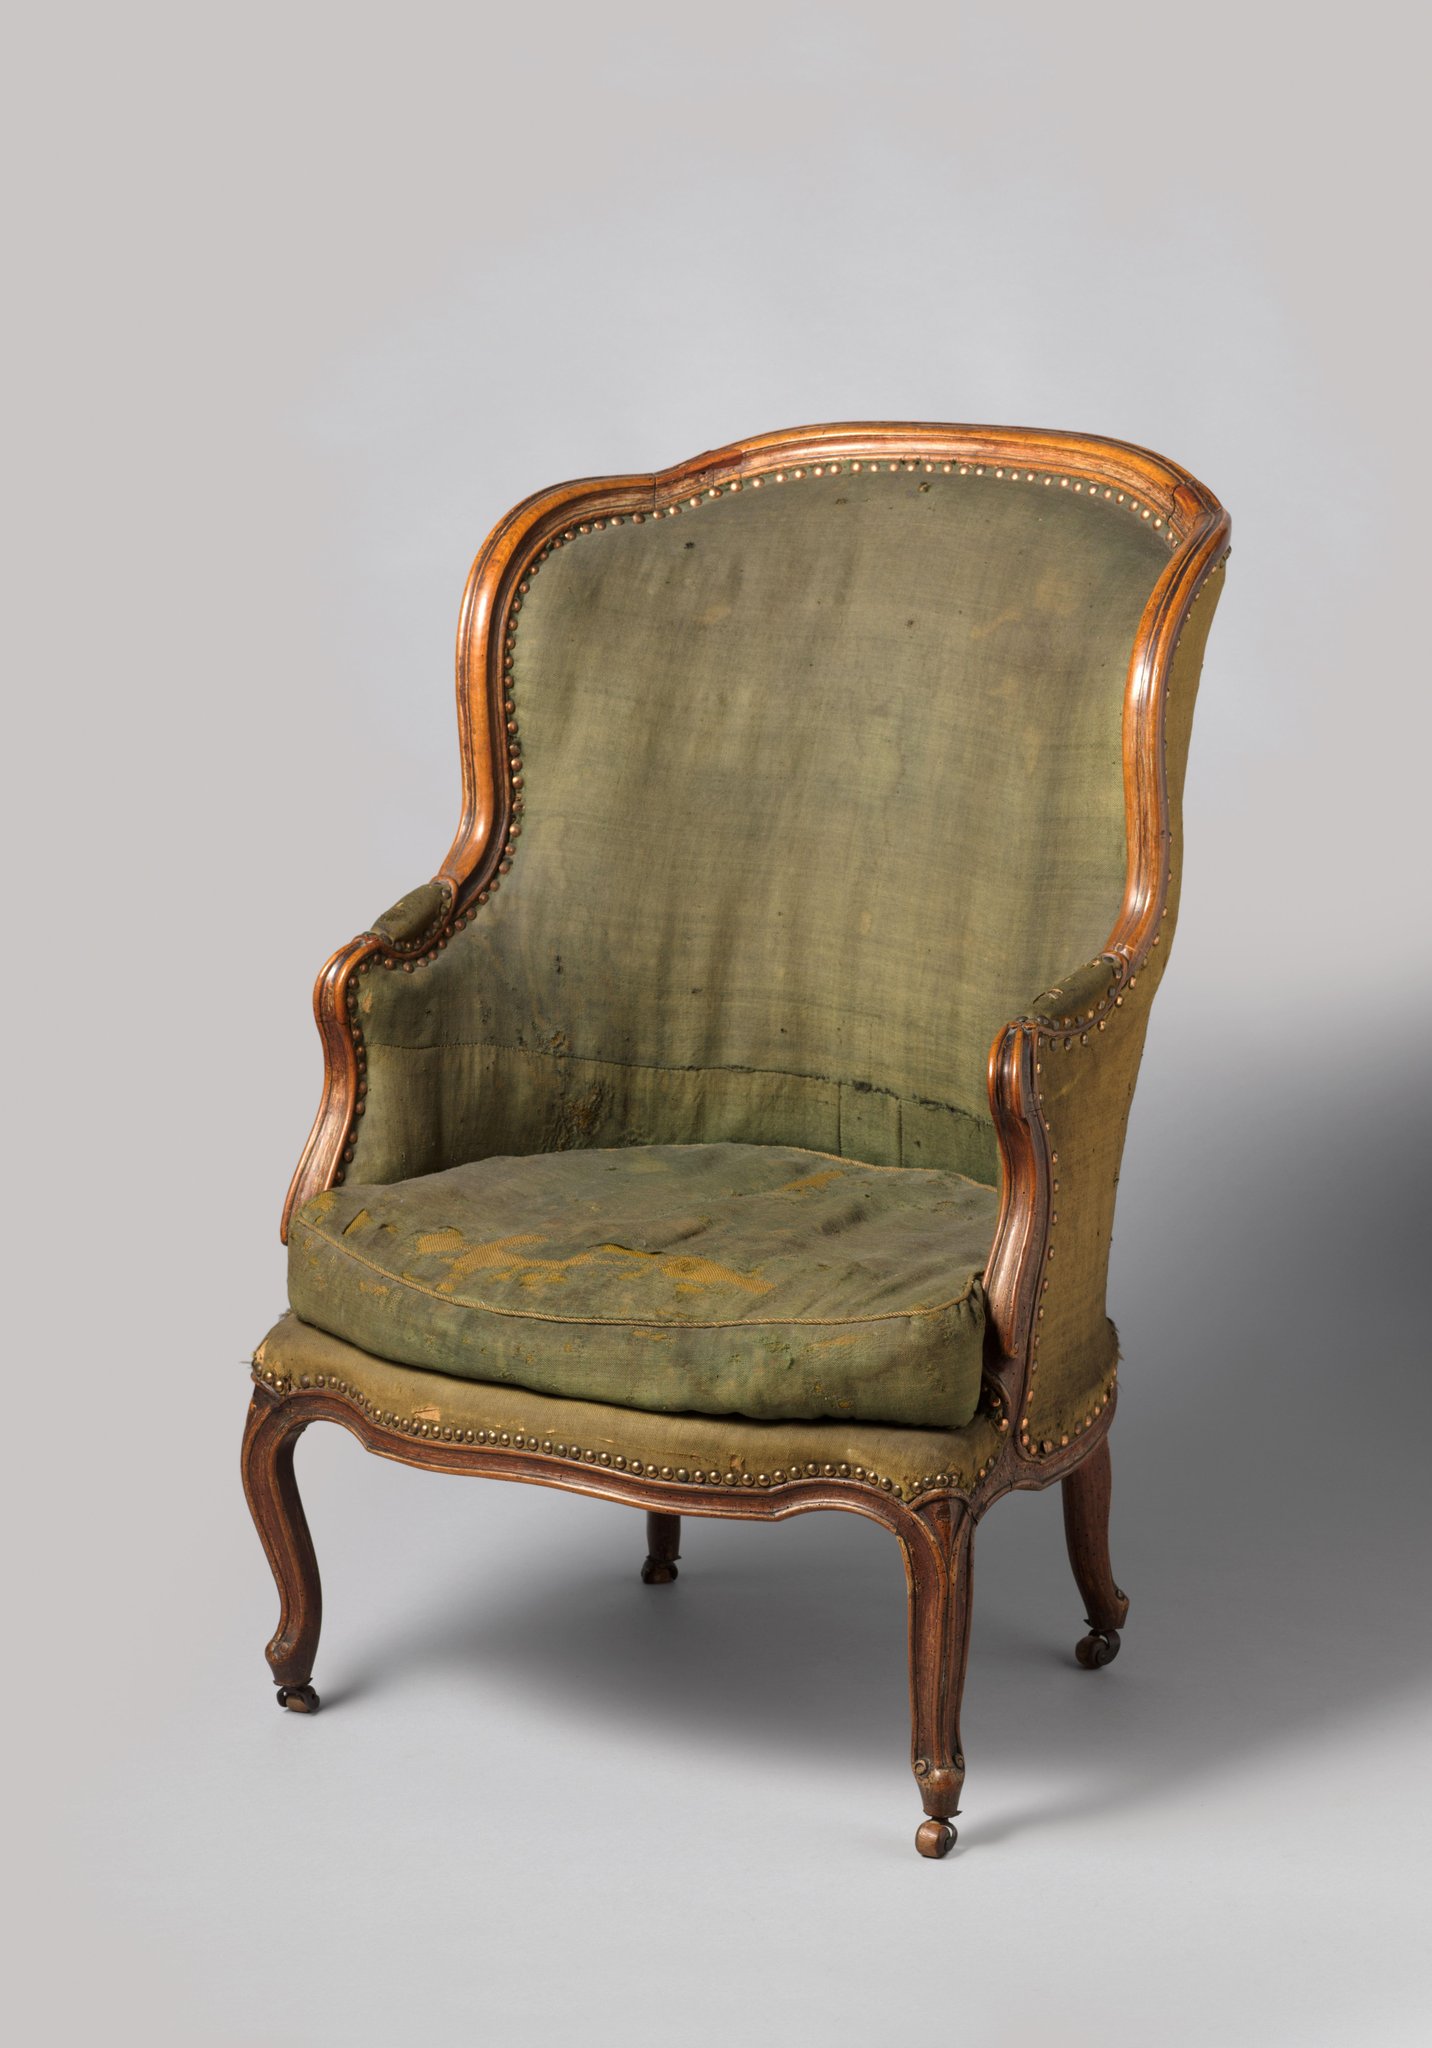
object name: seating furniture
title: Stoel van Willem Bilderdijk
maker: Anonymous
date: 1750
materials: textile, wood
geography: france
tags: amsterdam, haarlem, print maker, draughtsman, willem bilderdijk, netherlands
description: Bergère van notenhout, bekleed met groen saai en met een los kussen en hoofdrol. Het meubel rust op S-vormige poten, die zonder onderbreking in het zitraam overgaan. Het halfronde zitraam is aan de voorzijde geschulpt. De armleggers hebben kussentjes en eindigen in voluten. De armleggerstutten zijn achterwaarts geplaatst, komen uit het zitraam voort en gaan S-vormig in de armleggers over. Deze gaan weer zonder onderbreking in de wangen van het rugraam over. Bovendorpel is geschulpt. Profiellijsten rondom.